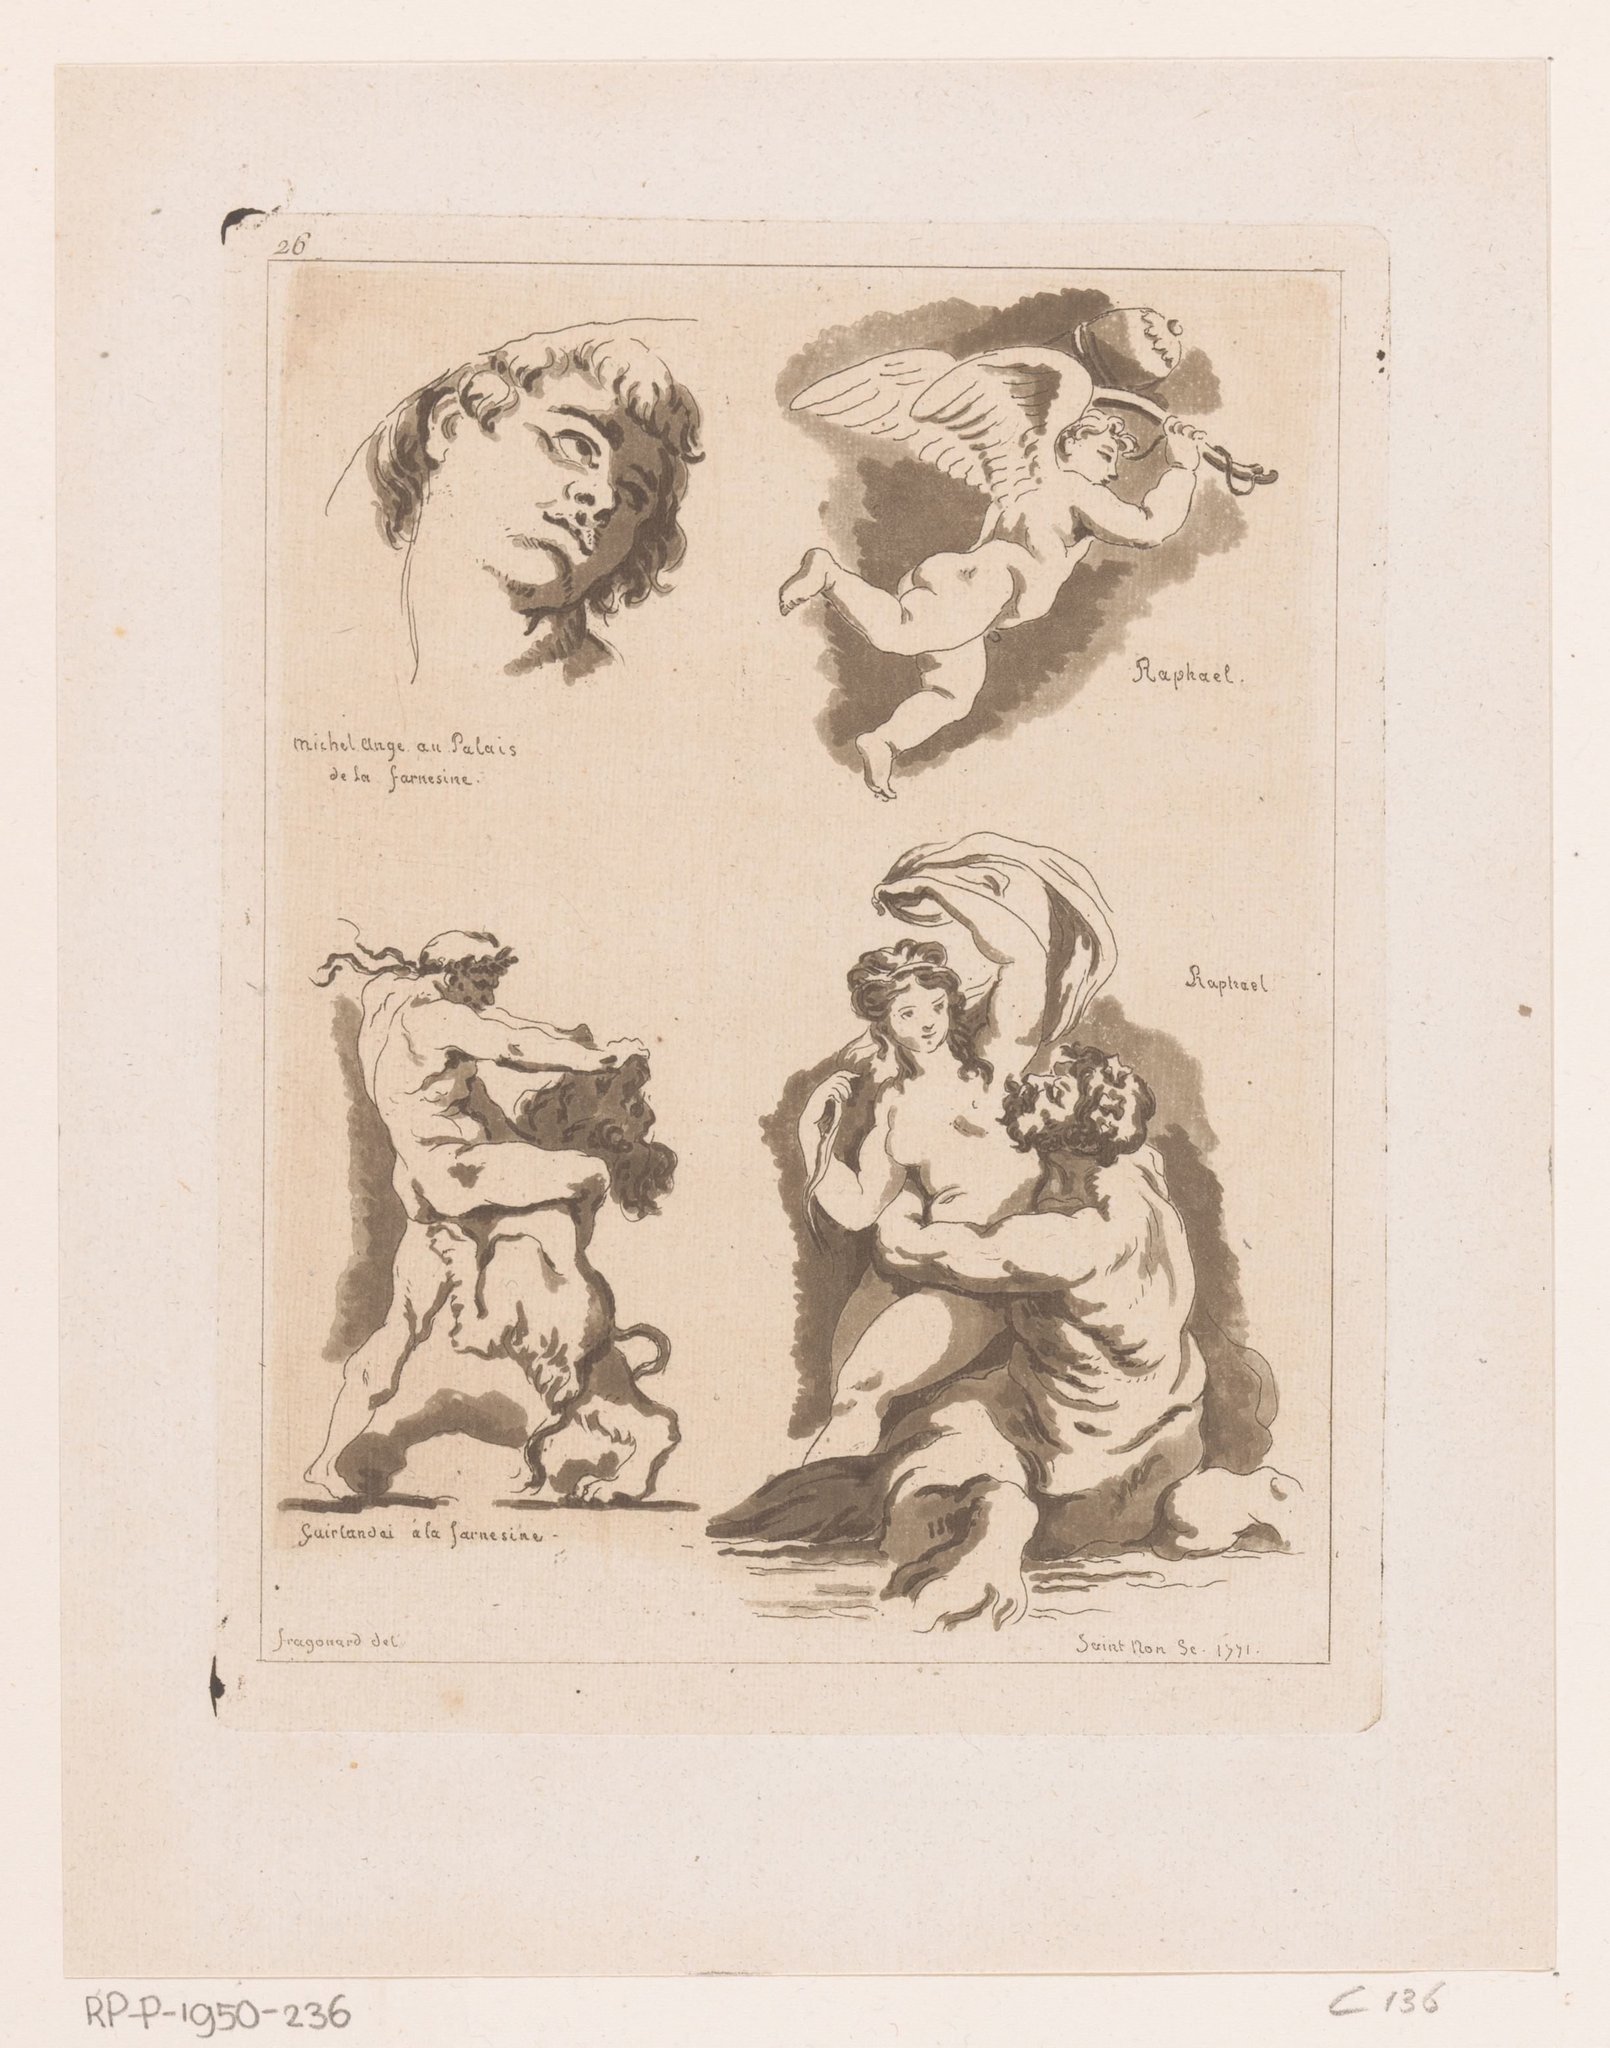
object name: print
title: Fragmenten gekozen uit schilderingen en schilderijen in Italië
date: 1771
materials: paper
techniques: aquatint, etching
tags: satyr(s) pursuing nymph(s), (story of) galatea; 'galatea' (ripa), man struggling with animals, the (nude) human figure; 'corpo humano' (ripa) (+ nude human being), cupids: 'amores', 'amoretti', 'putti'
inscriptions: collector's mark: Lugt 2228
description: Prent maakt deel uit van een serie met daarbinnen delen over specifiek Rome, Bologna, Napels en Venetië.